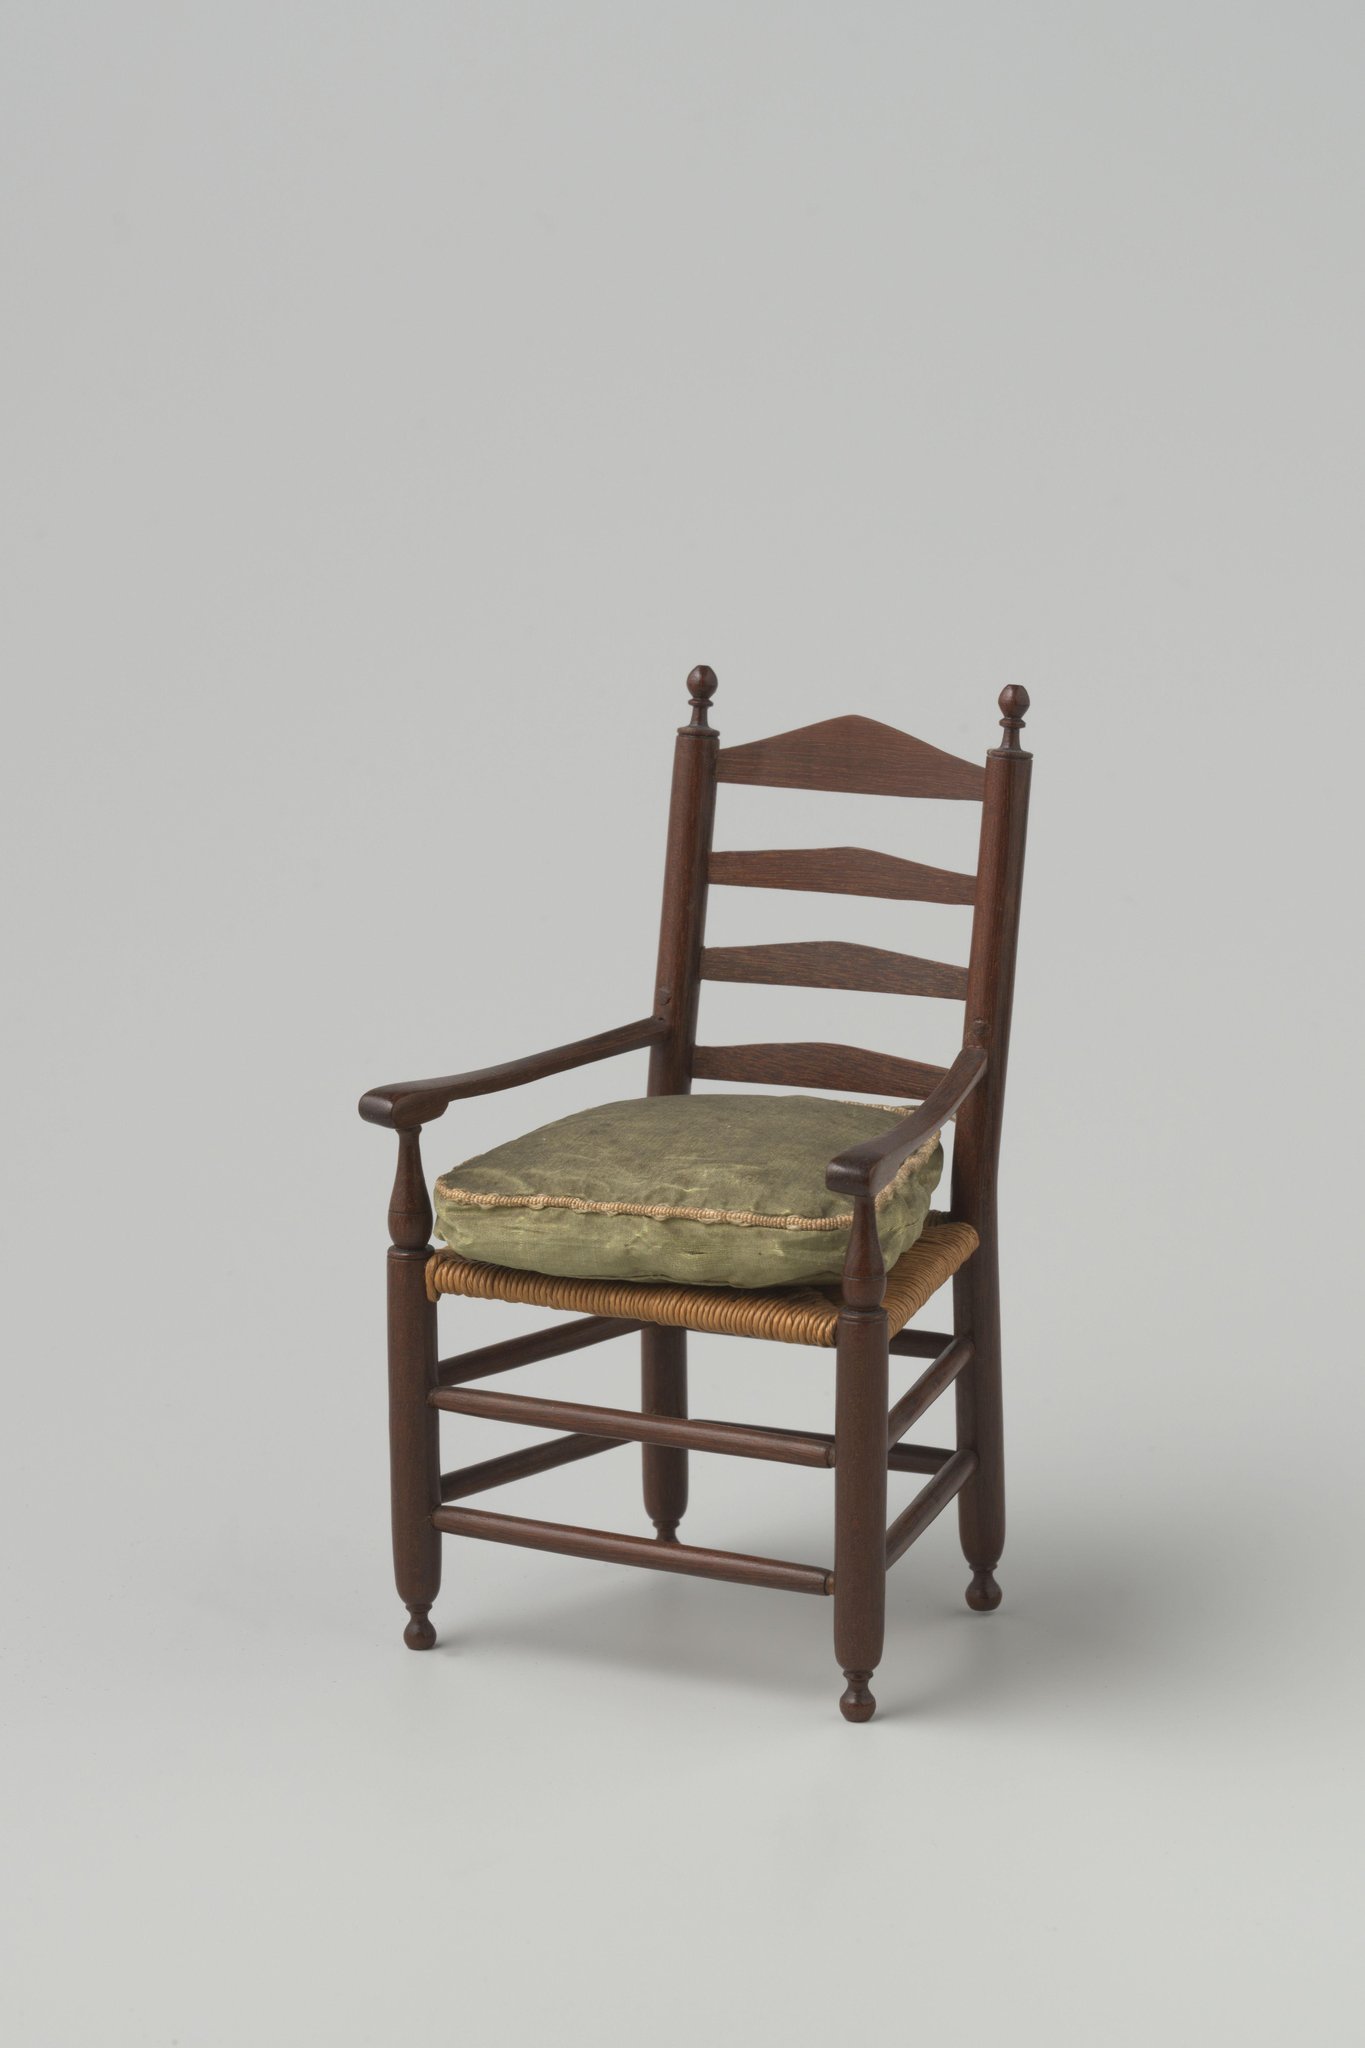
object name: chair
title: Knopstoel vervaardigd van hardhout met gladde, gedraaide stijlen en dwarsregels, voorpoten en achterstijlen eindigend in fijn gedraaide knoppen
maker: Anonymous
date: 1690-1710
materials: down, wood, linen, silk, fiber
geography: amsterdam